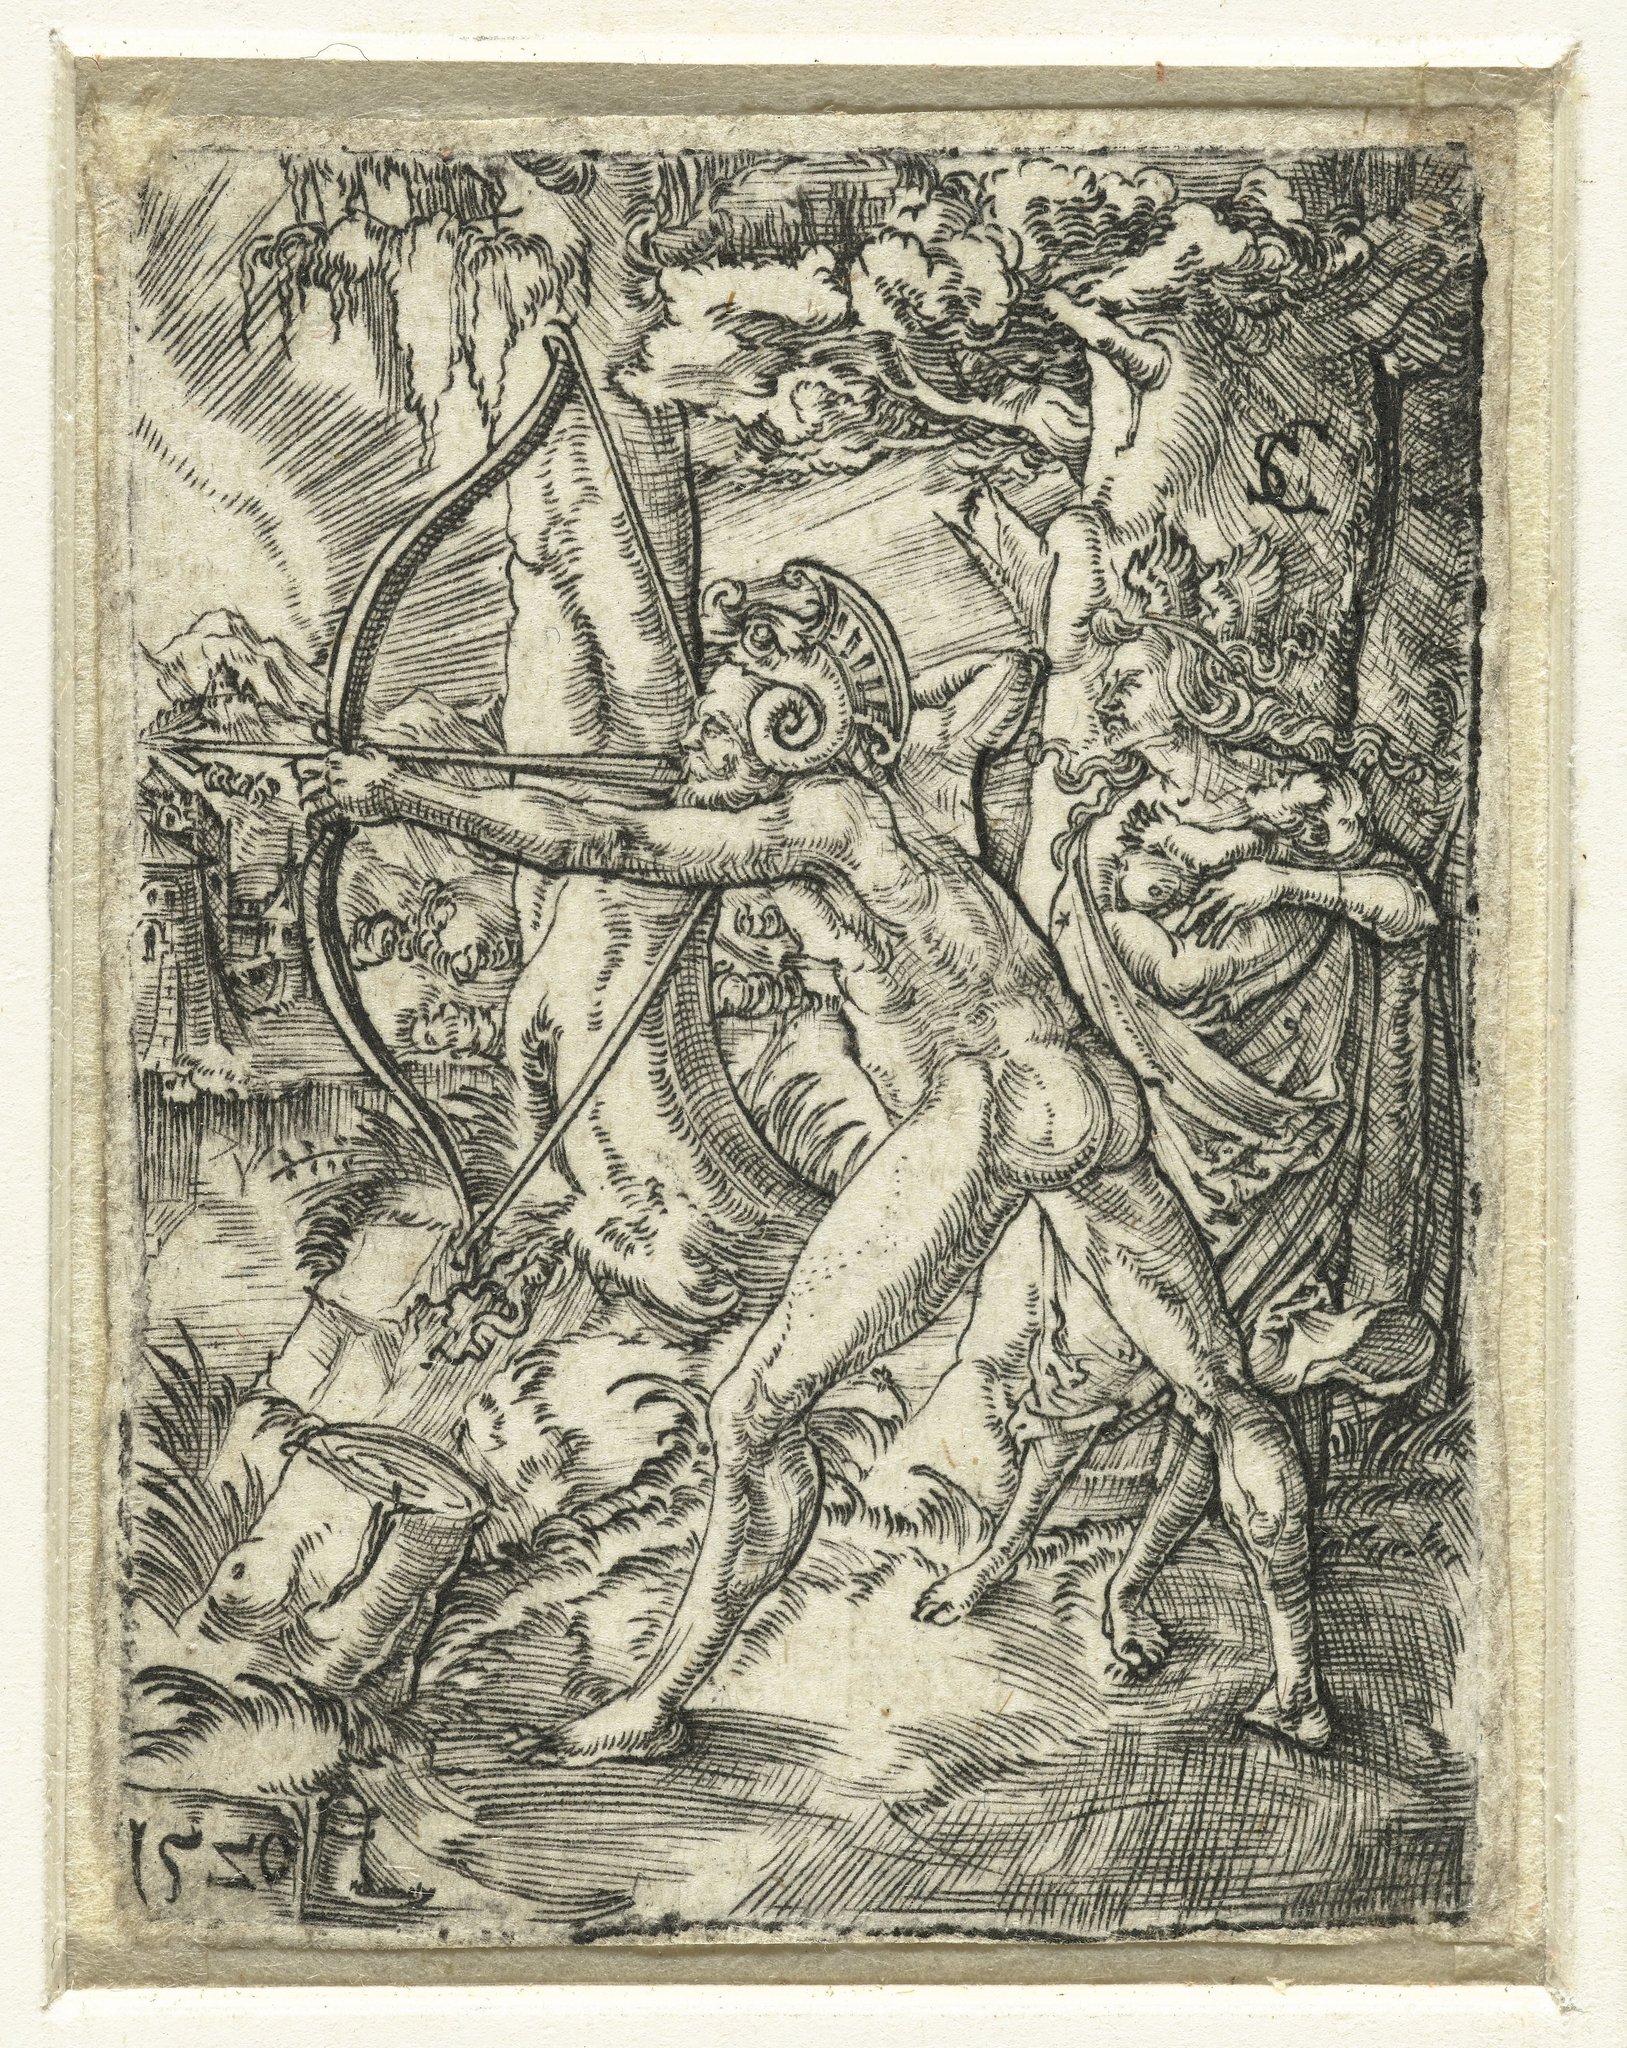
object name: print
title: De wilden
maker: monogrammist sc (graveur)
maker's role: print maker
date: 1520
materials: paper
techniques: engraving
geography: germany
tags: wild man, wodewose, woodehouse, wild man, wodewose, woodehouse - aa - female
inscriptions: number: ‘21,4-103’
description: Een naakte wilde man met pijl en boog, achter hem zijn vrouw met een kind in de armen.